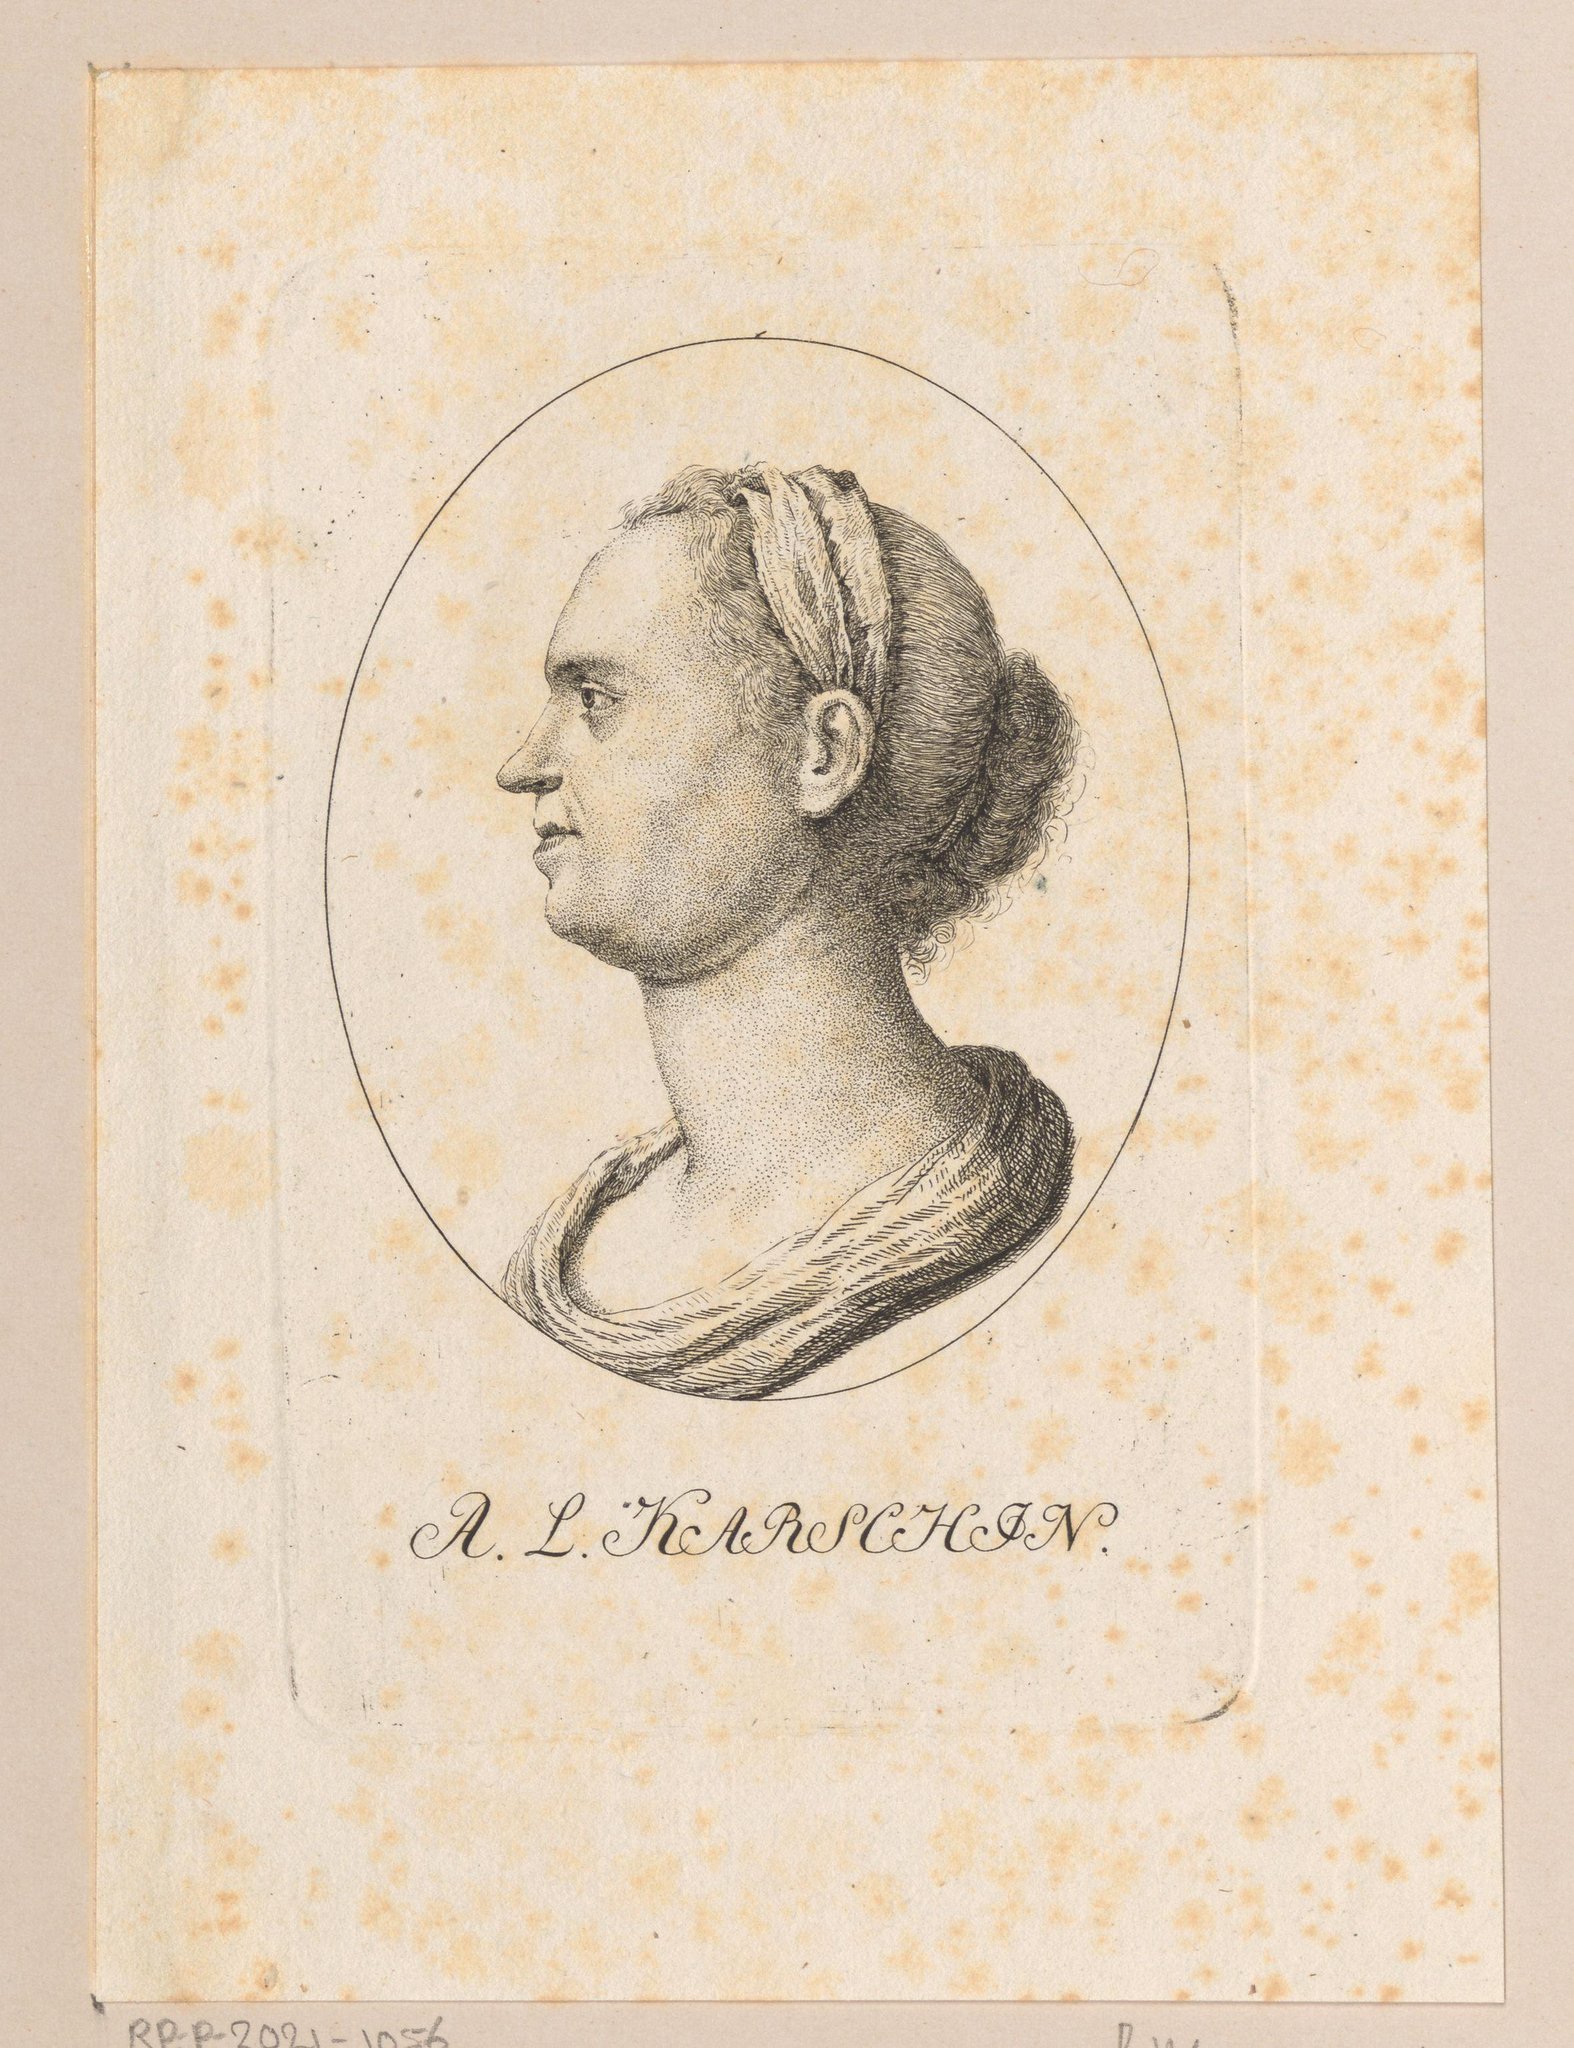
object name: print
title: Portret van Anna Luise Karsch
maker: Anonymous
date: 1737-1799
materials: paper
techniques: etching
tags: historical persons - bb - woman, writer, poet, author